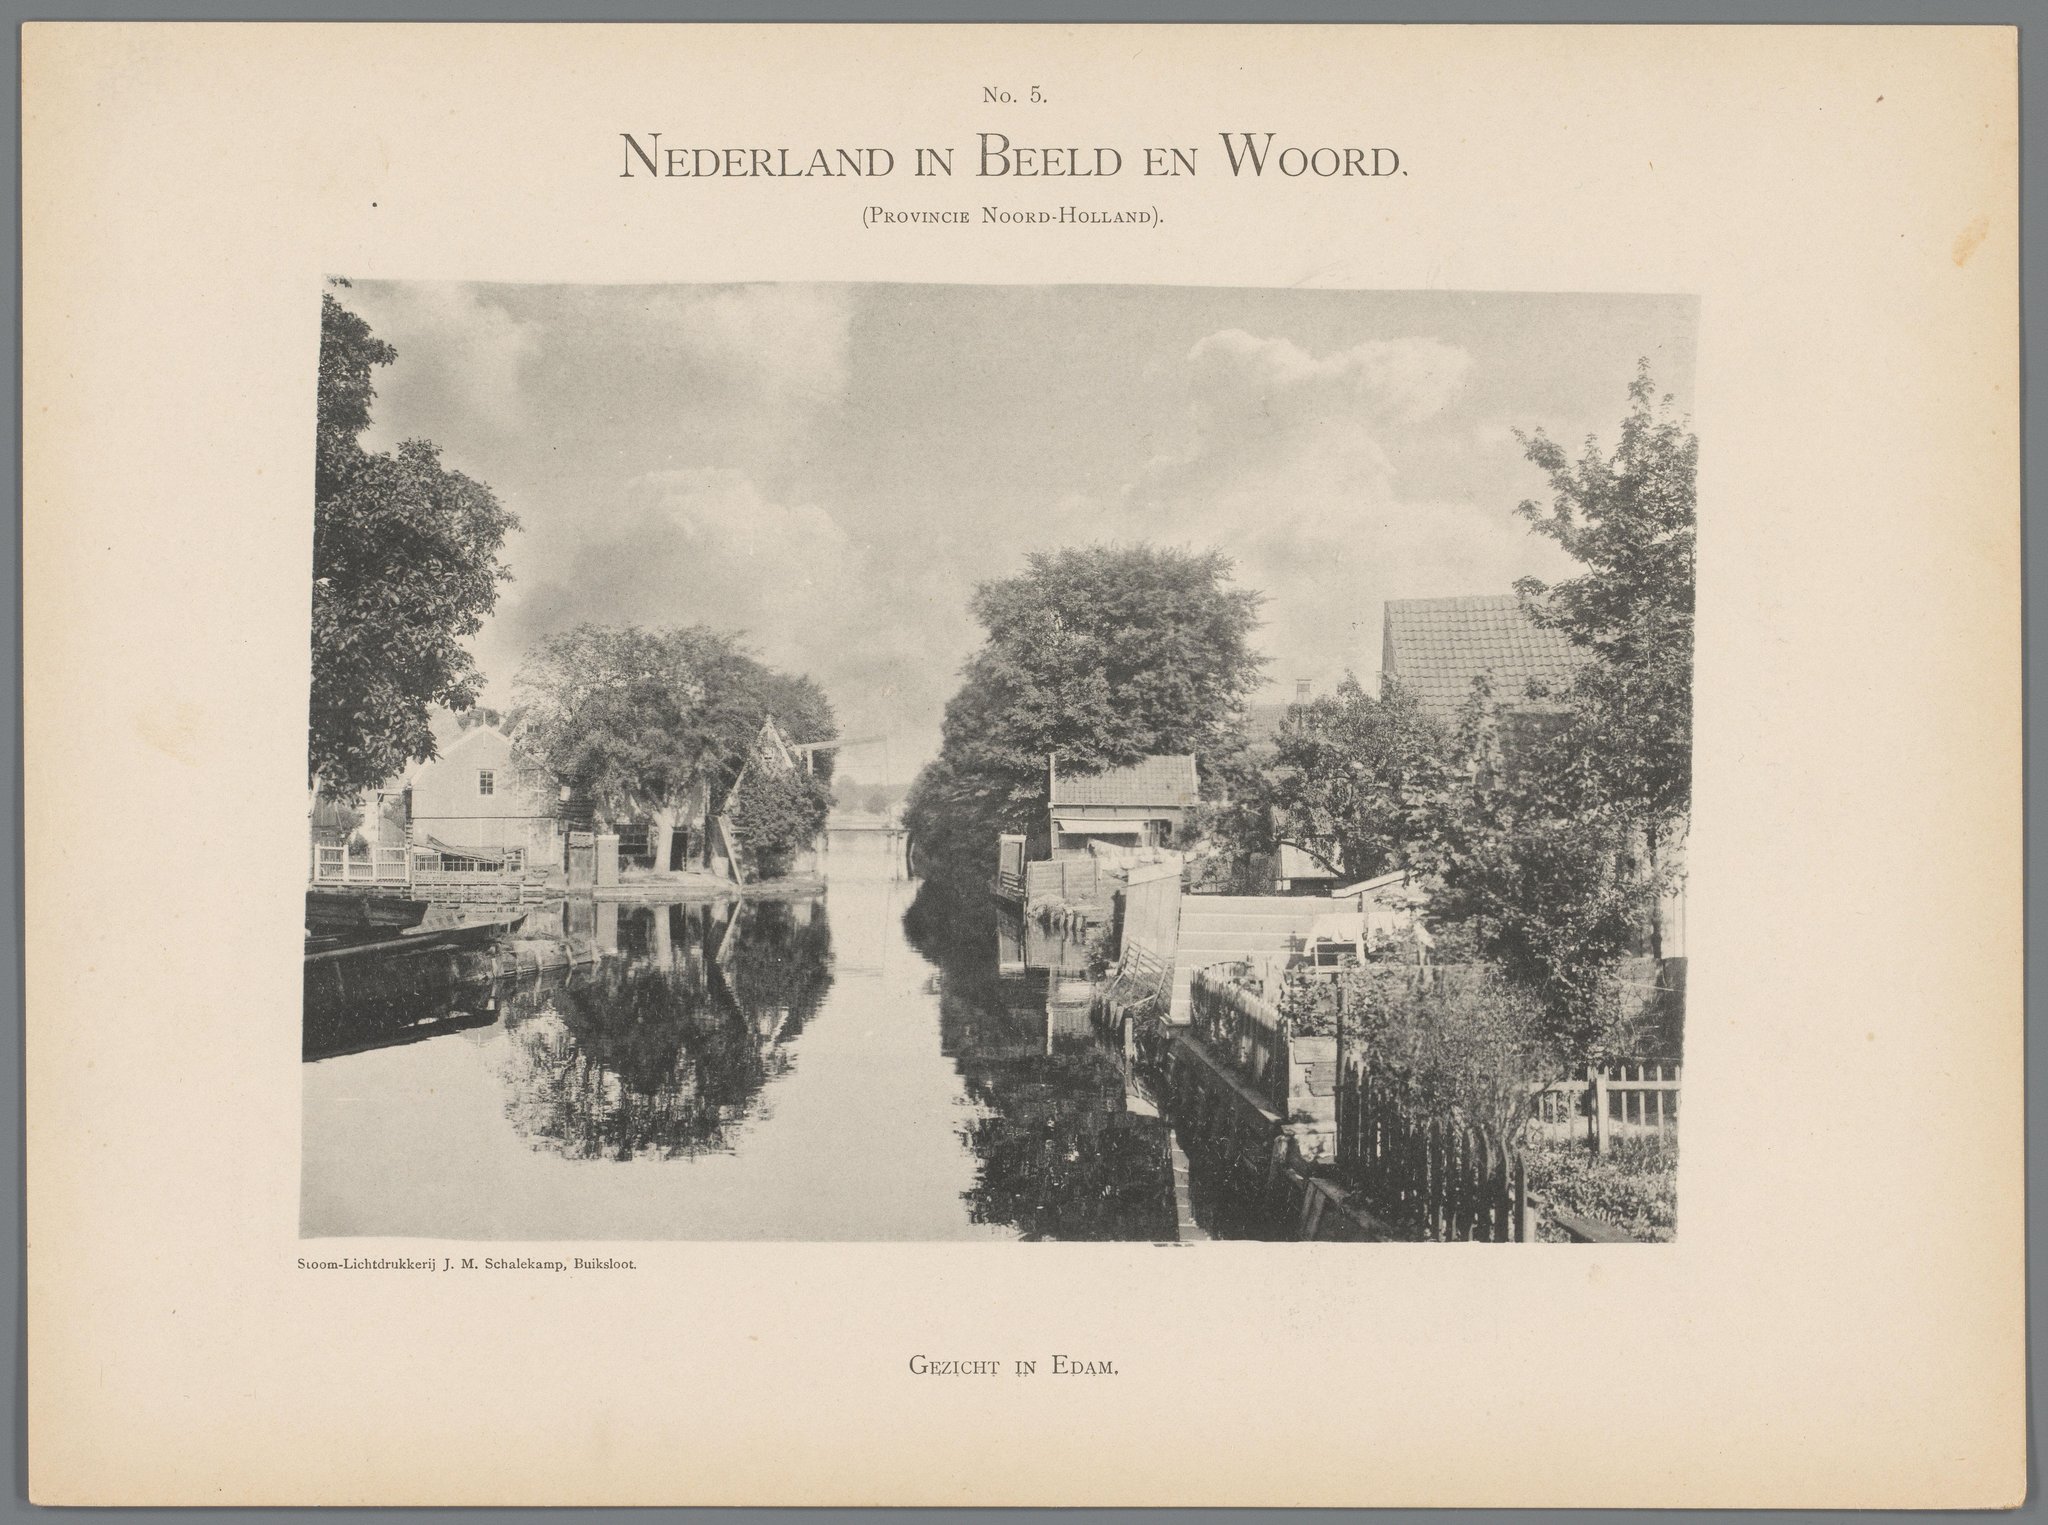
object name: photomechanical print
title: Gezicht in Edam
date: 1890-1895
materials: cardboard, paper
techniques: photograph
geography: edam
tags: canals, waters (in village)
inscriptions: number: ‘No. 5.’